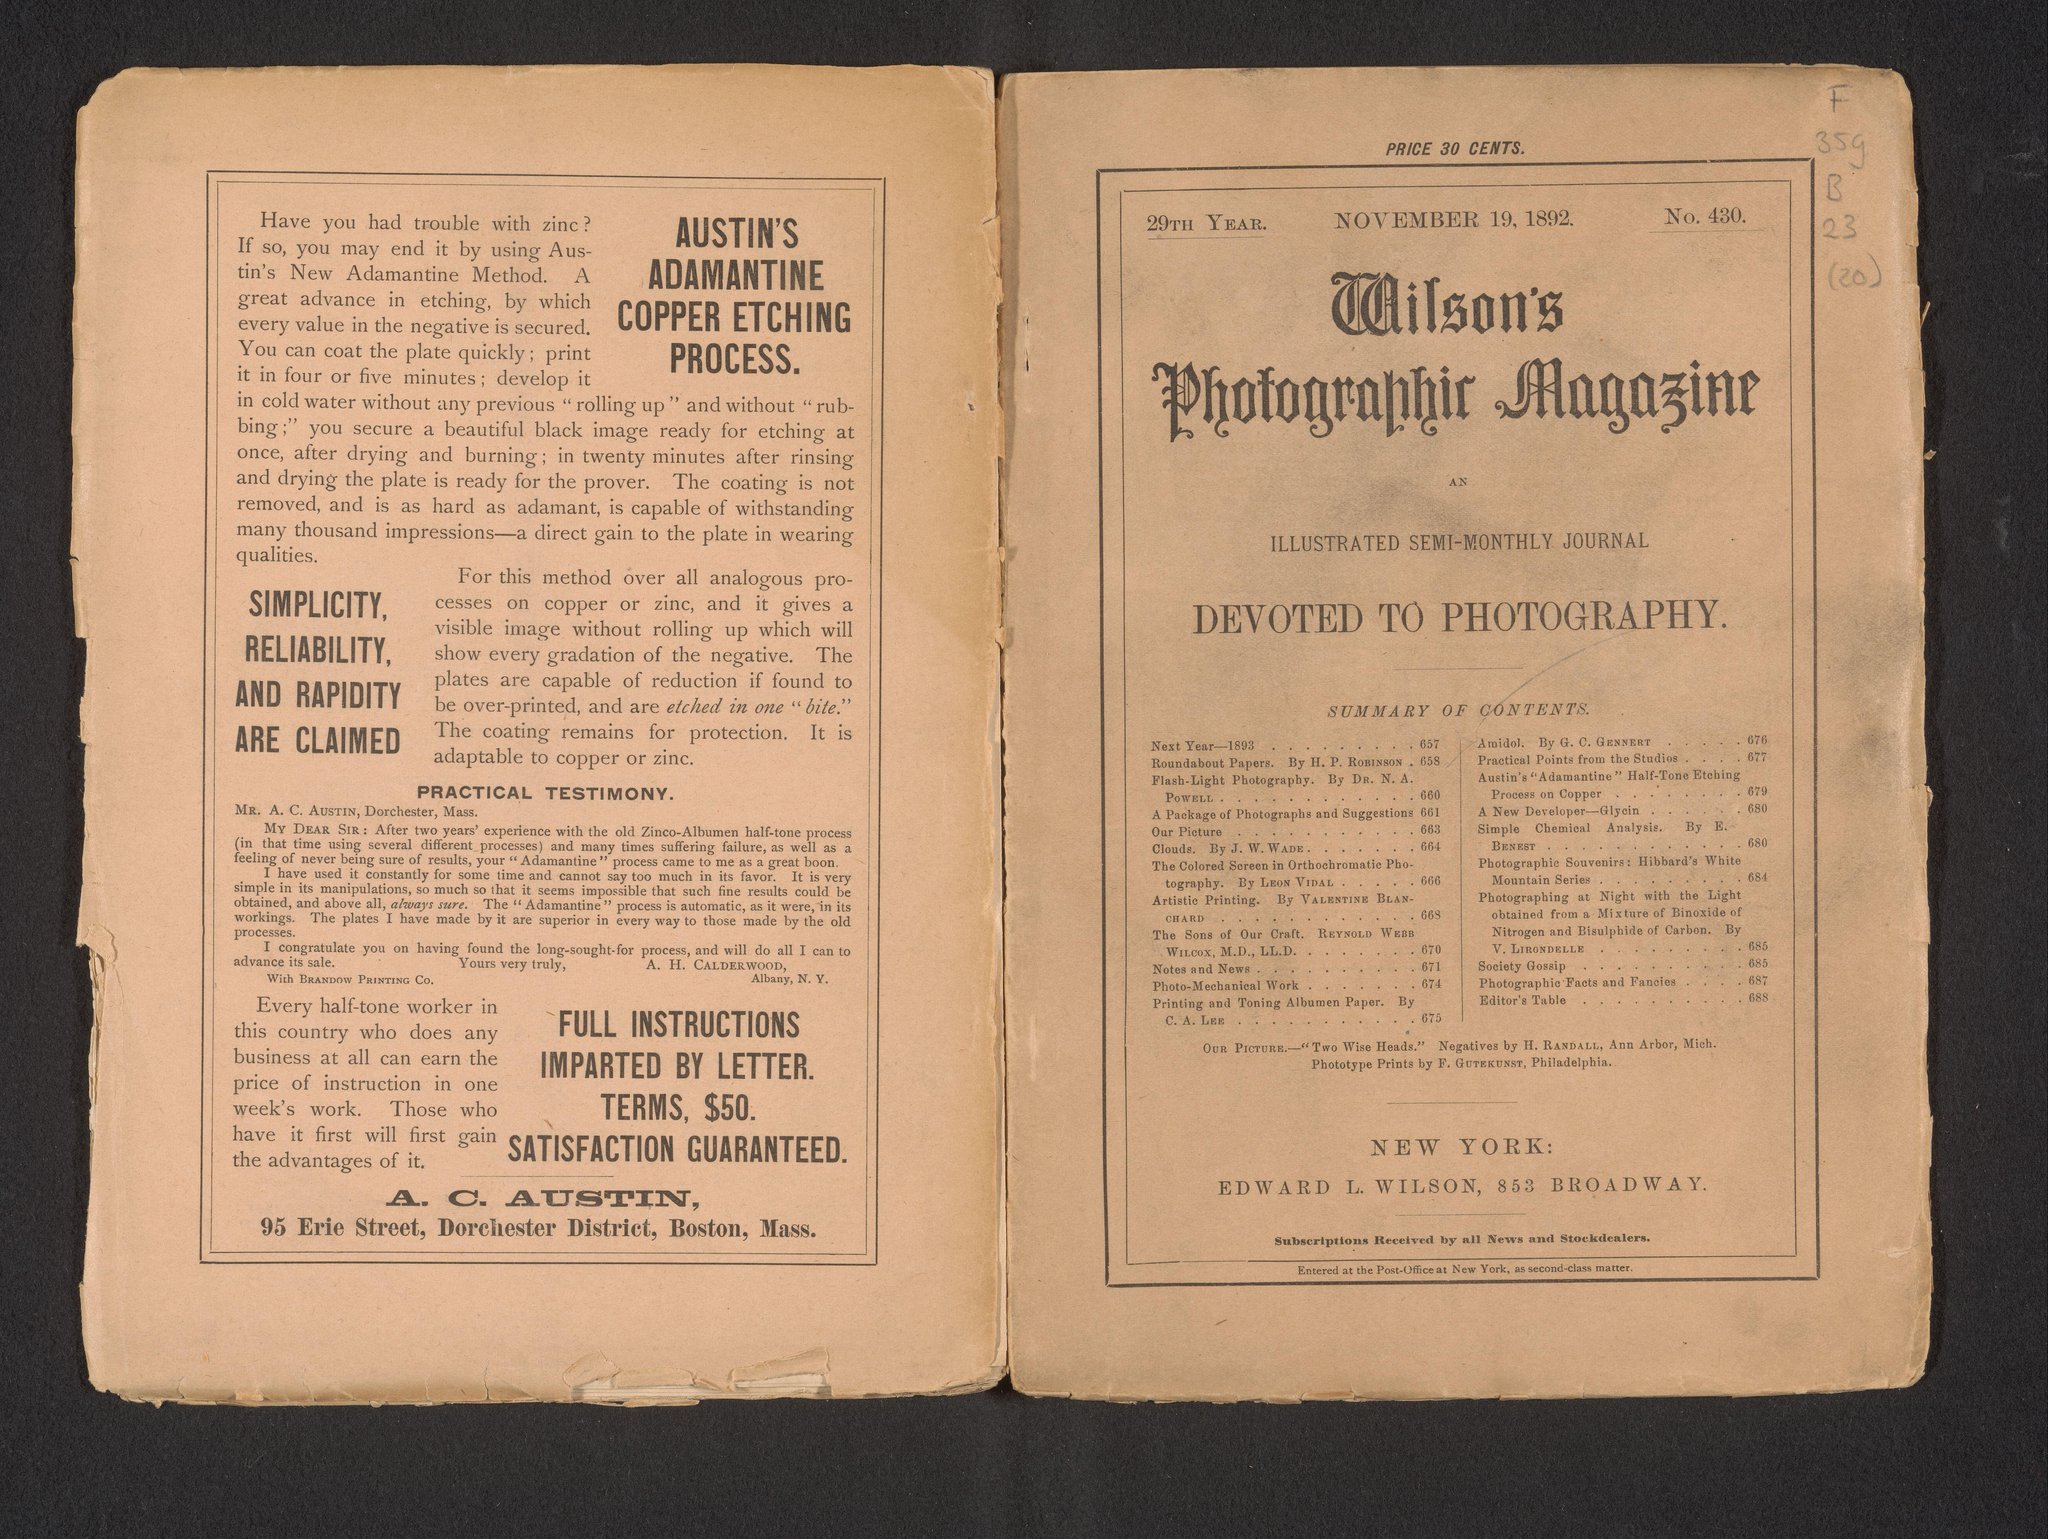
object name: magazine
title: Wilson's photographic magazine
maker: edward livingston wilson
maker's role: publisher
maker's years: 1838-1903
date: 1892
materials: paper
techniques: photograph, printing, engraving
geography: new york city